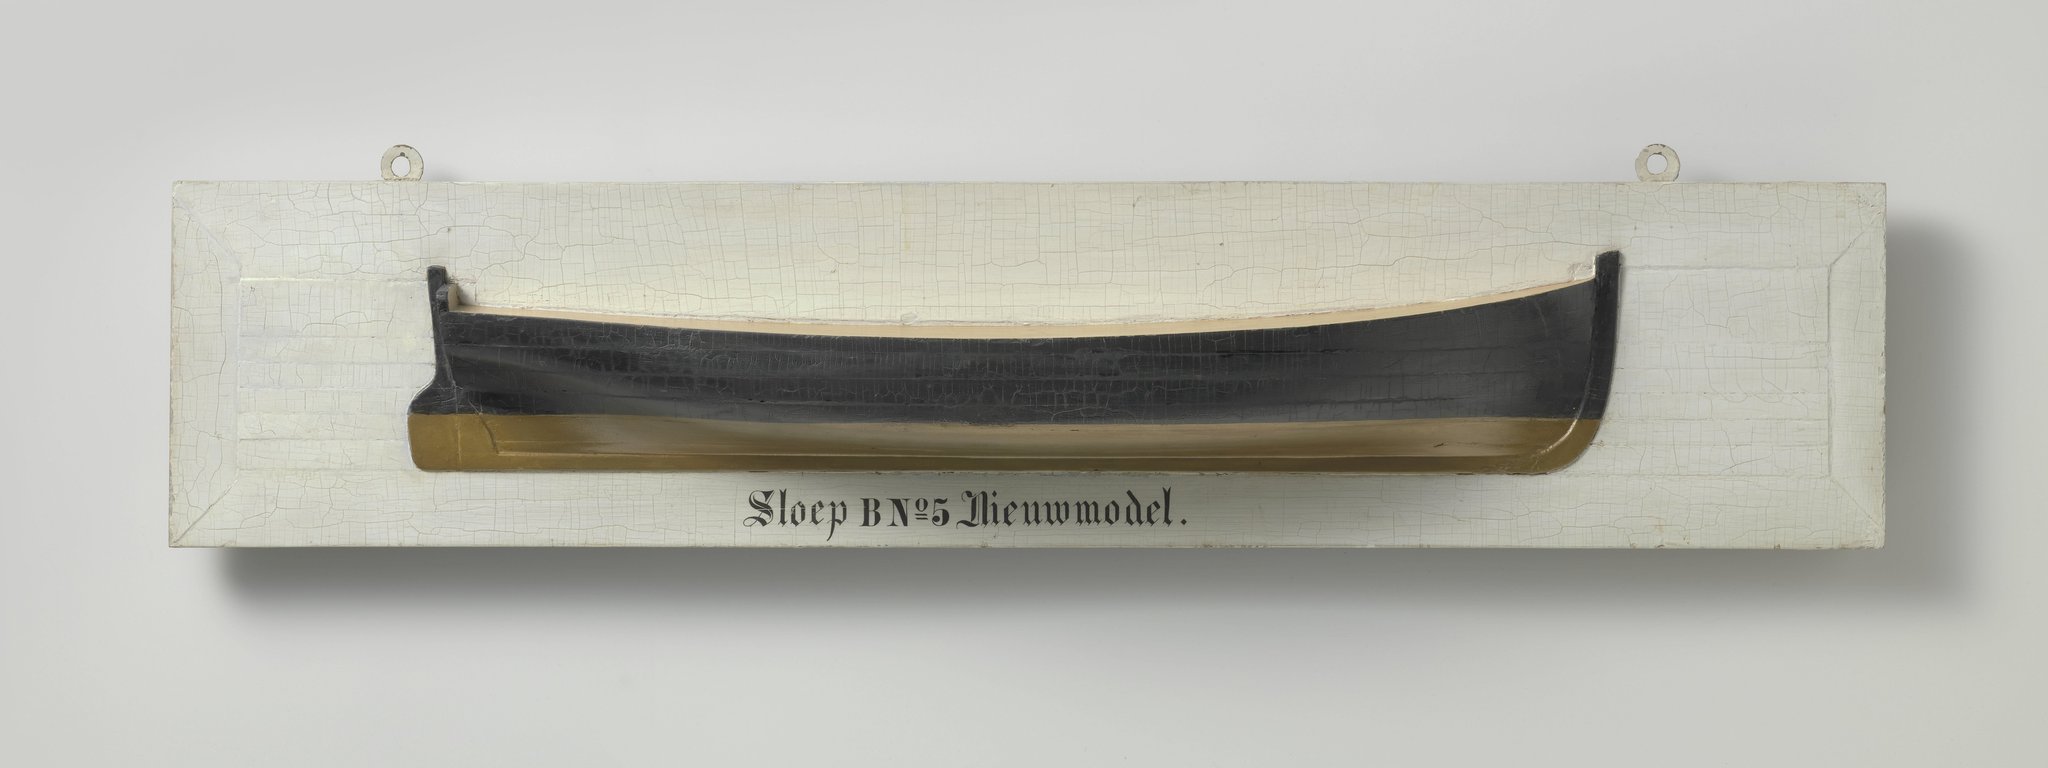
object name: builder's model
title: Half Model of a Launch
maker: Anonymous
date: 1860-1880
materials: wood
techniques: polychromy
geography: indonesian archipelago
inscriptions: inscription, bottom centre, in a Gothic hand: ‘Sloep BN° 5 Nieuwmodel.’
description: De bepalingen voor barkassen en reddingboten werden in 1865 herzien. Dit model behoort duidelijk tot de serie Oost-Indische halfmodellen (NG-MC-1889-14 & 15).